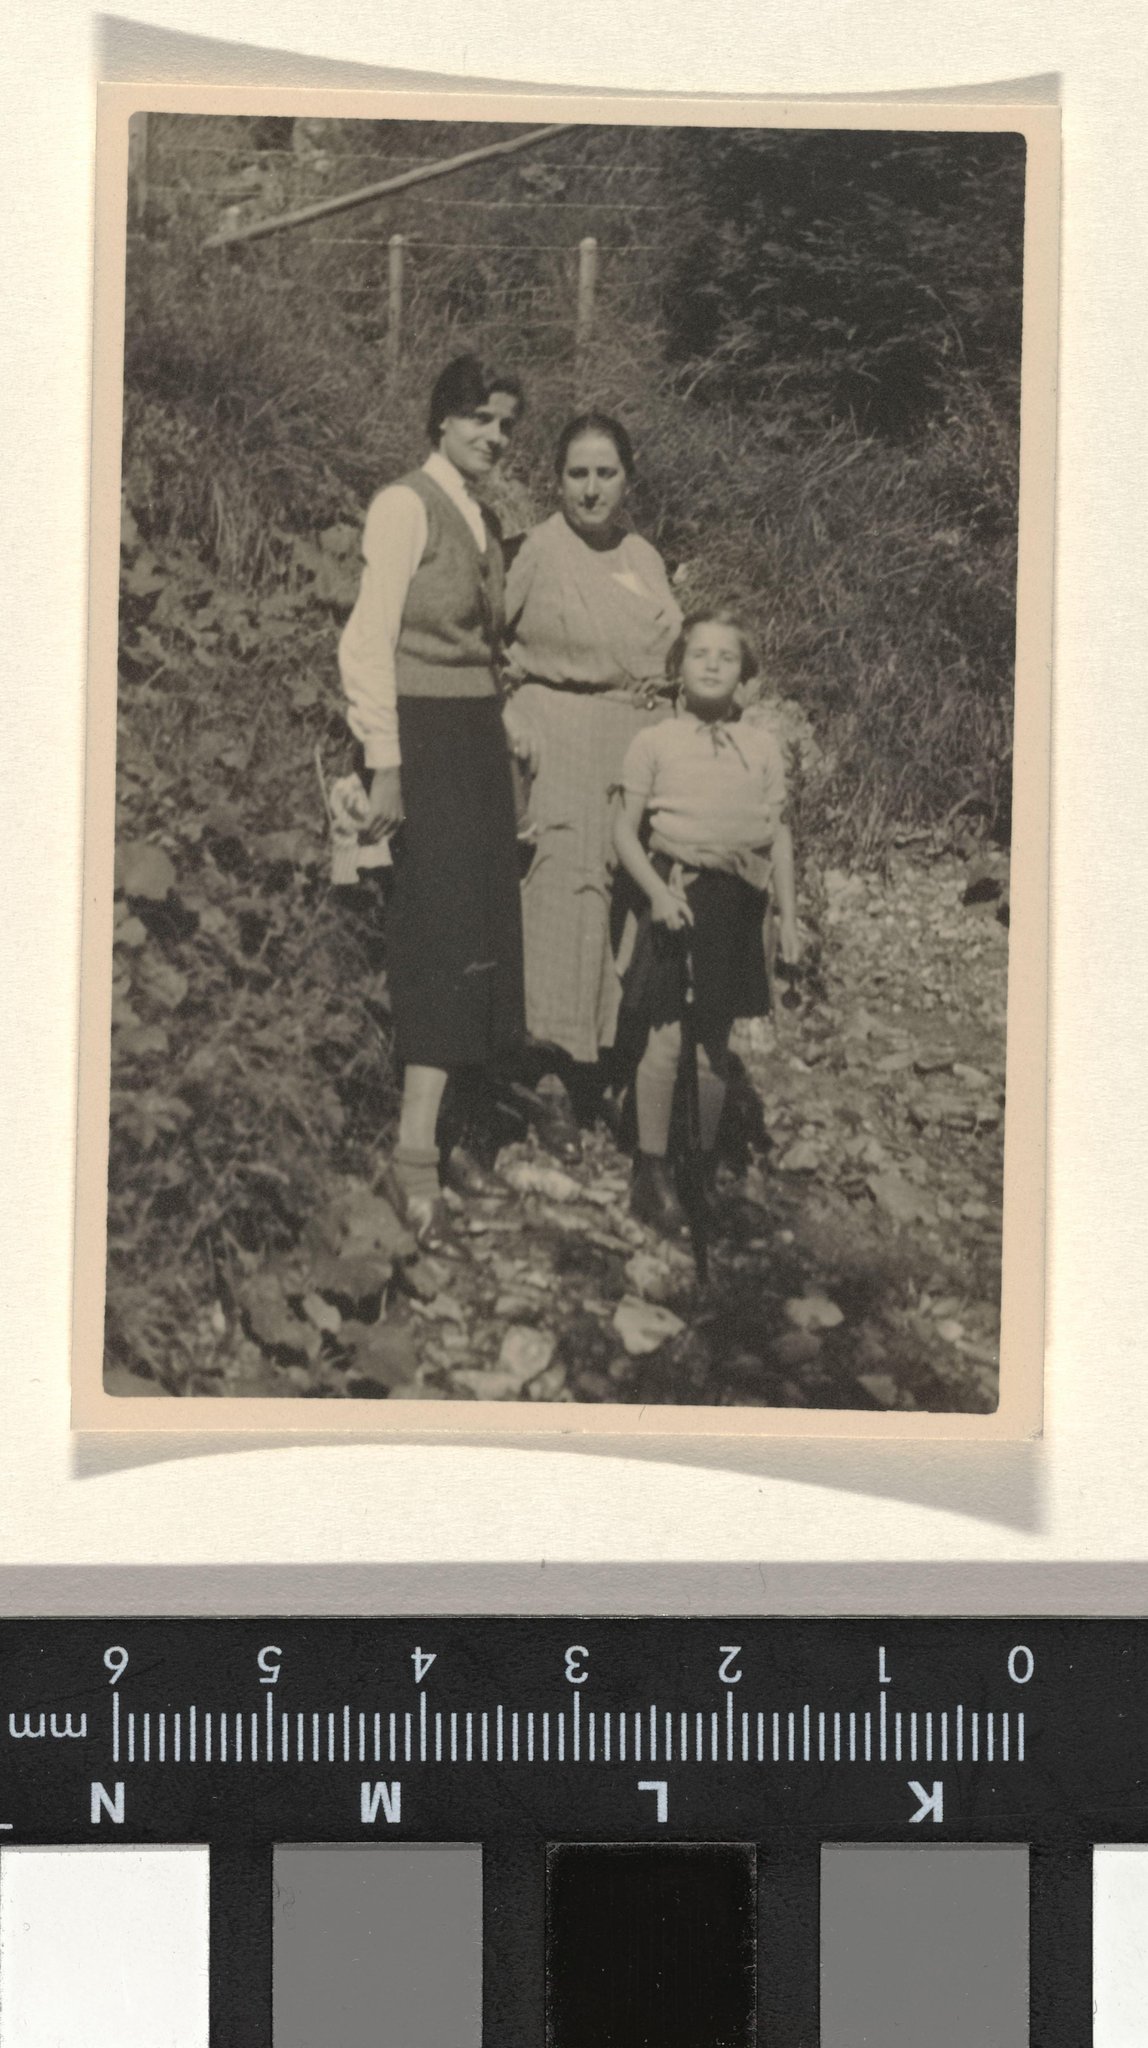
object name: photograph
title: Else en Isabel Wachenheimer en een lid van de huishoudelijke staf bij Adelboden, augustus 1935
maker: Anonymous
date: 1908-1935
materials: photographic support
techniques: gelatin silver print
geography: adelboden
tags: else wachenheimer-moos, leiden, isabel wachenheimer-elon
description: Dit object is onderdeel van de nalatenschap van Isabel Elon-Wachenheimer (1928-2010). Tot haar overlijden behoorde het samen met de andere objecten uit de nalatenschap tot haar privédomein van Isabel Wachenheimer. In die particuliere context zijn deze objecten tezamen en individueel aandenkens - aan de jeugd, ouders en familie van Isabel Wachenheimer vóór en tijdens de Shoah en aan haar leven na de Tweede Wereldoorlog. Isabel Wachenheimer, die van juni 1943 tot mei 1945 gevangen zat in Kamp Westerbork, Theresienstadt, Auschwitz, Lenzing a/d Oberdonau (een buitenkamp van Mauthausen), overleefde de Shoah. Haar ouders – Eugène Wachenheimer en Else Wachenheimer-Moos - werden op 14 oktober 1944 in Auschwitz-Birkenau vermoord.